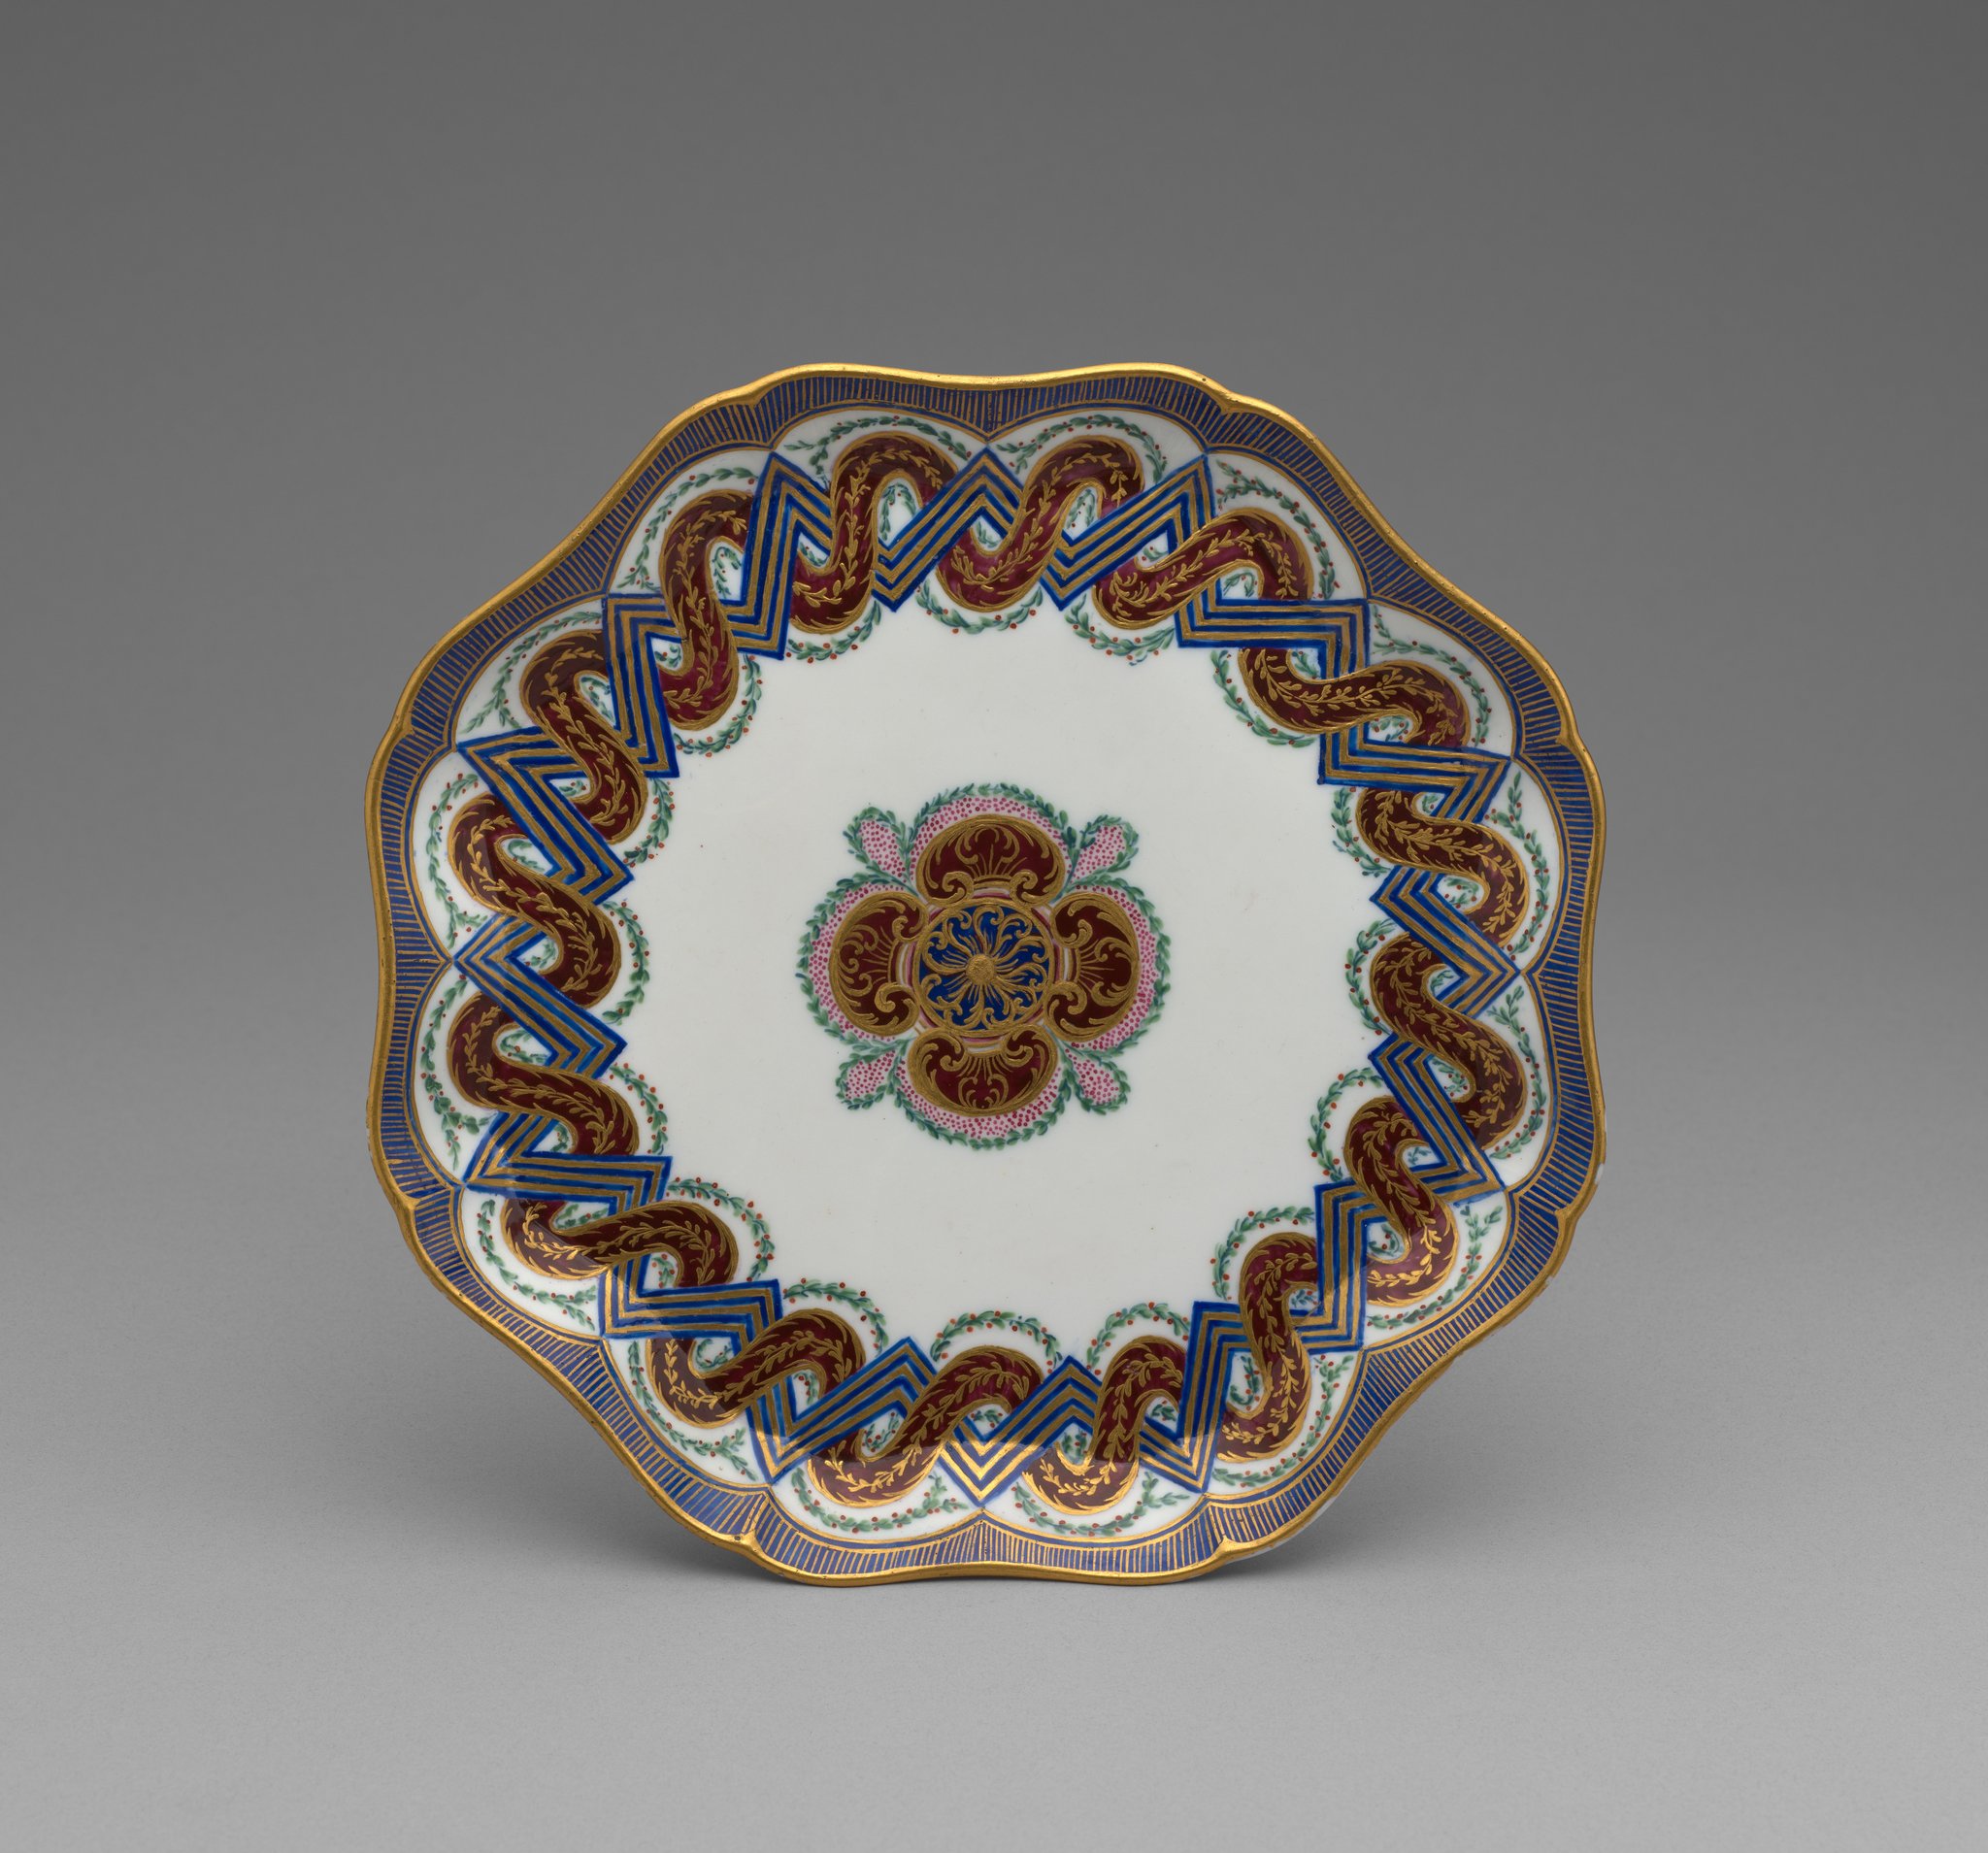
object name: tray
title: Octagonal tray (plateau octogone) (part of a déjeuner service)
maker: sèvres manufactory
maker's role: maker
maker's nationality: french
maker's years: 1740-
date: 1763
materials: soft paste porcelain